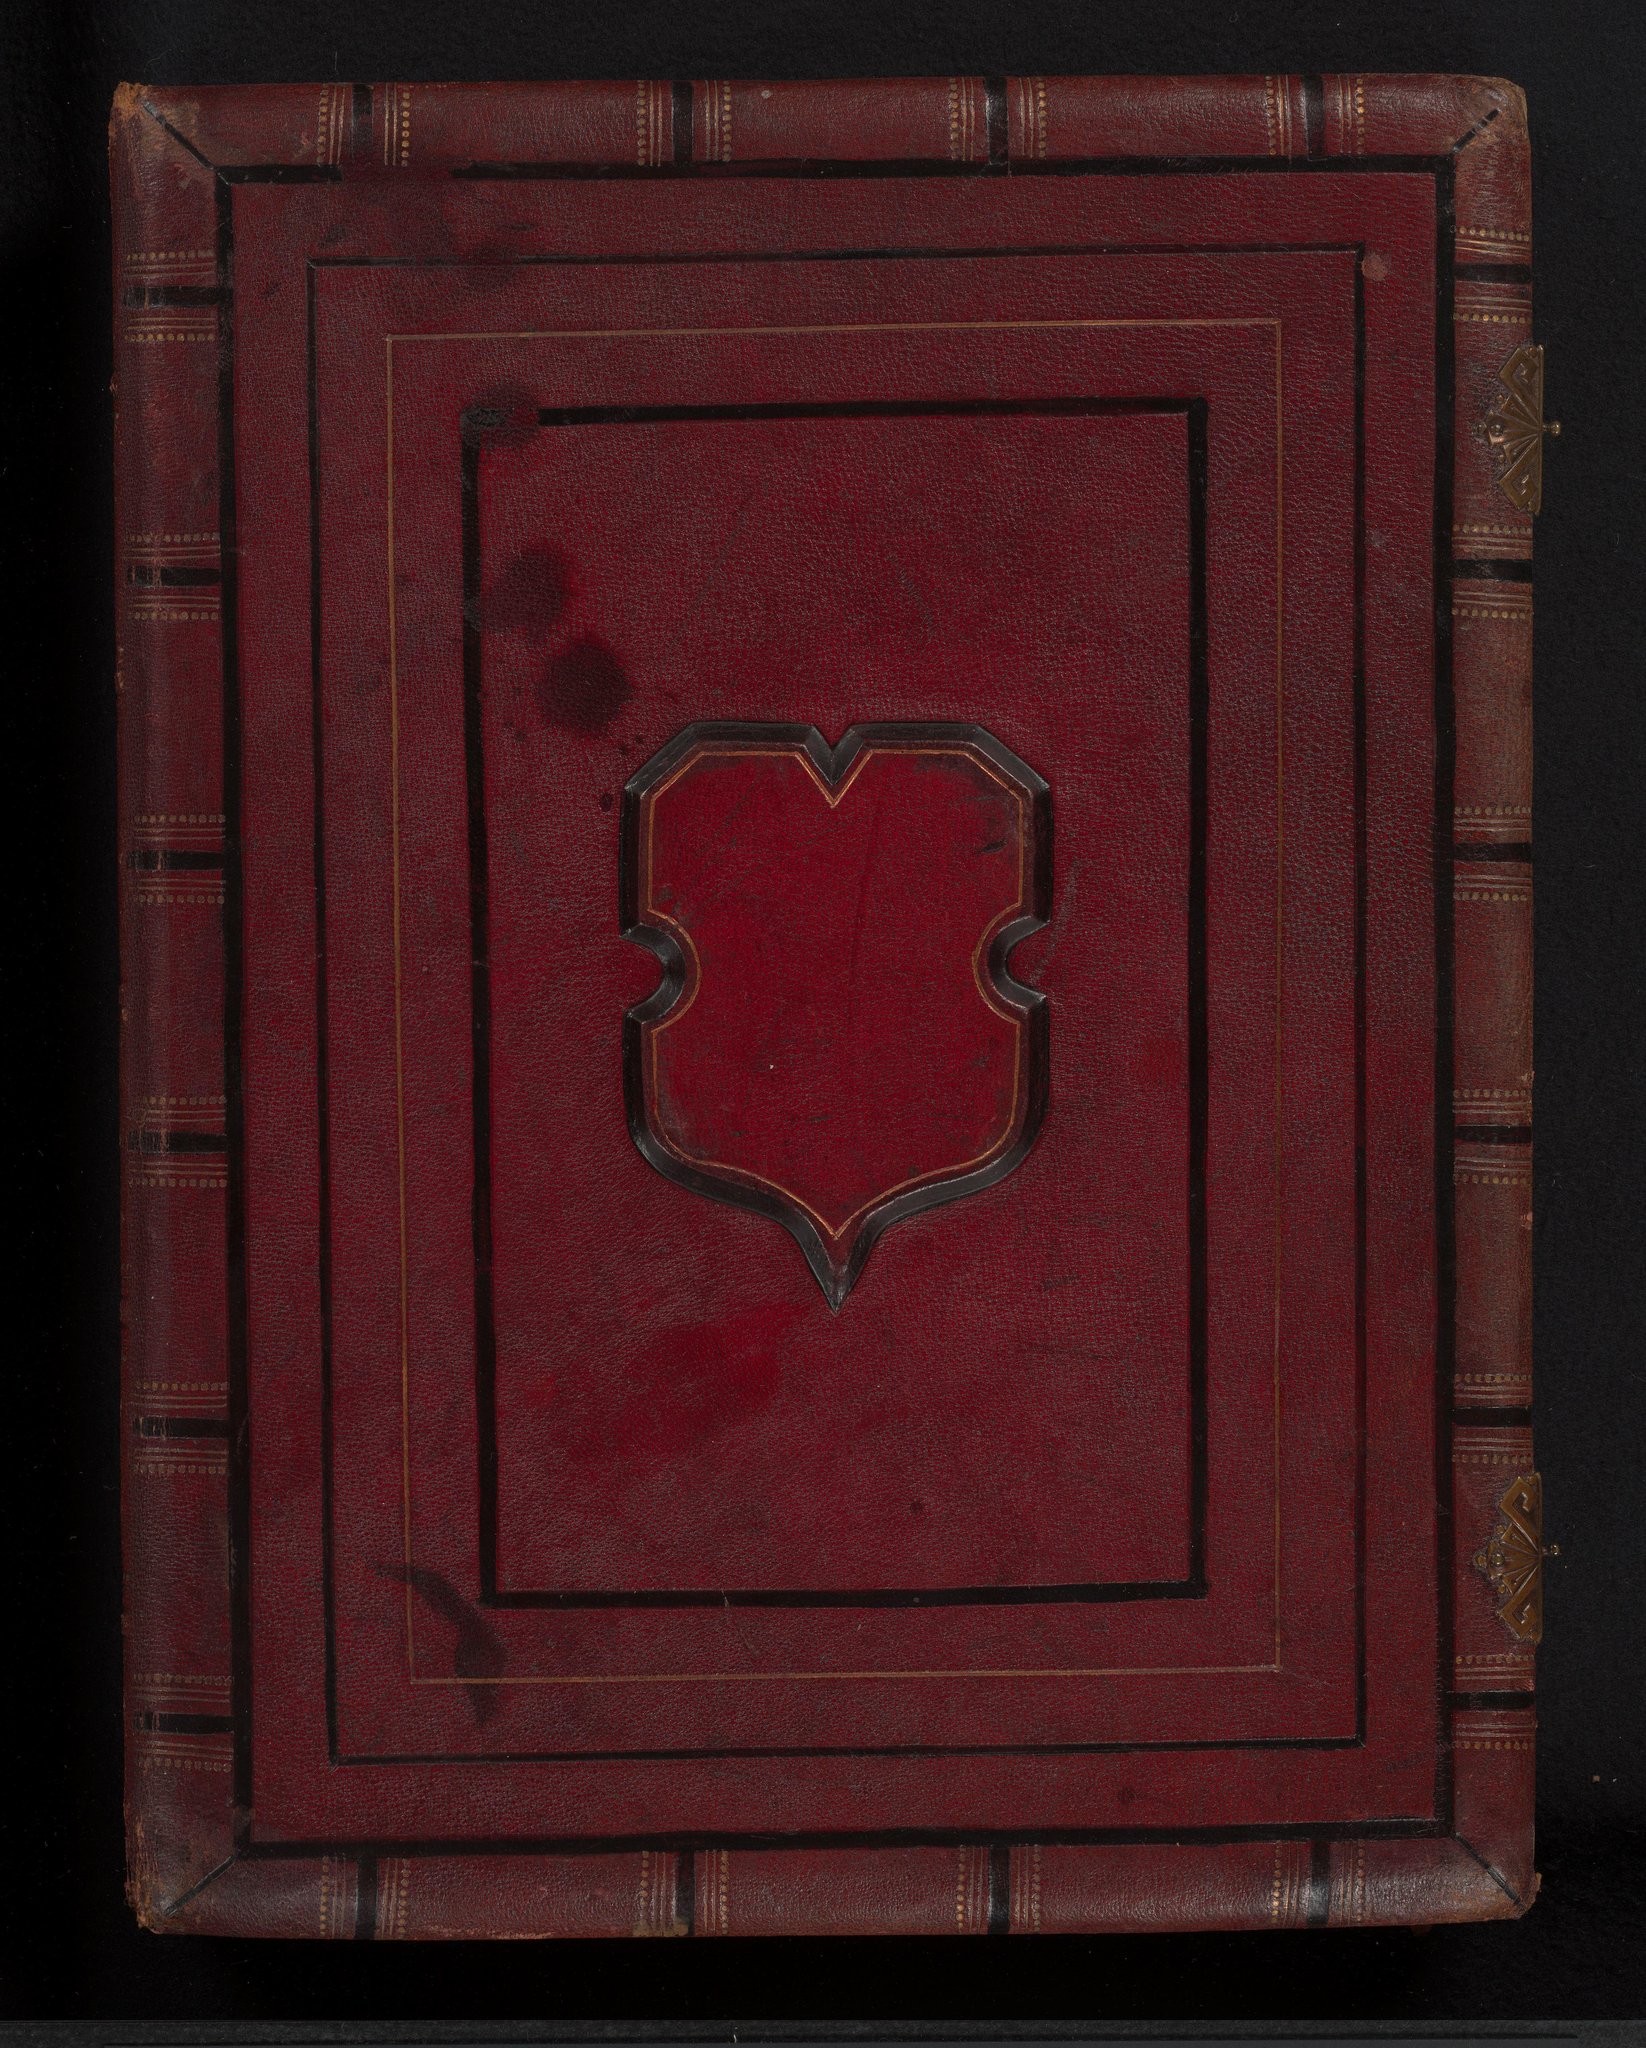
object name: slip in album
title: Familie-album met 67 foto's, Frans en Belgisch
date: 1850-1900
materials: cardboard, leather, metal, paper, photographic support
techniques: albumen print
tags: sitting figure - aa - female human figure, historical persons - bb - woman, moustache, historical persons, girl (child between toddler and youth), head-gear: hat, beard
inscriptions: collector's mark: ‘Dienst Verspreide Rijkskollekties (...) Inv.nr.: A1028’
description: Fotoalbum met 13 bladen met in totaal 67 cartes-de-visite. Het album bevat portretten voornamelijk vervaardigd in Frankrijk en België, met name in Brussel. Twee cartes-de-visite hebben een opdracht aan J. Bruyneel. De foto's zijn onder andere vervaardigd door Albert Delabarre, Ghémar Frères en César Mitkiewicz.